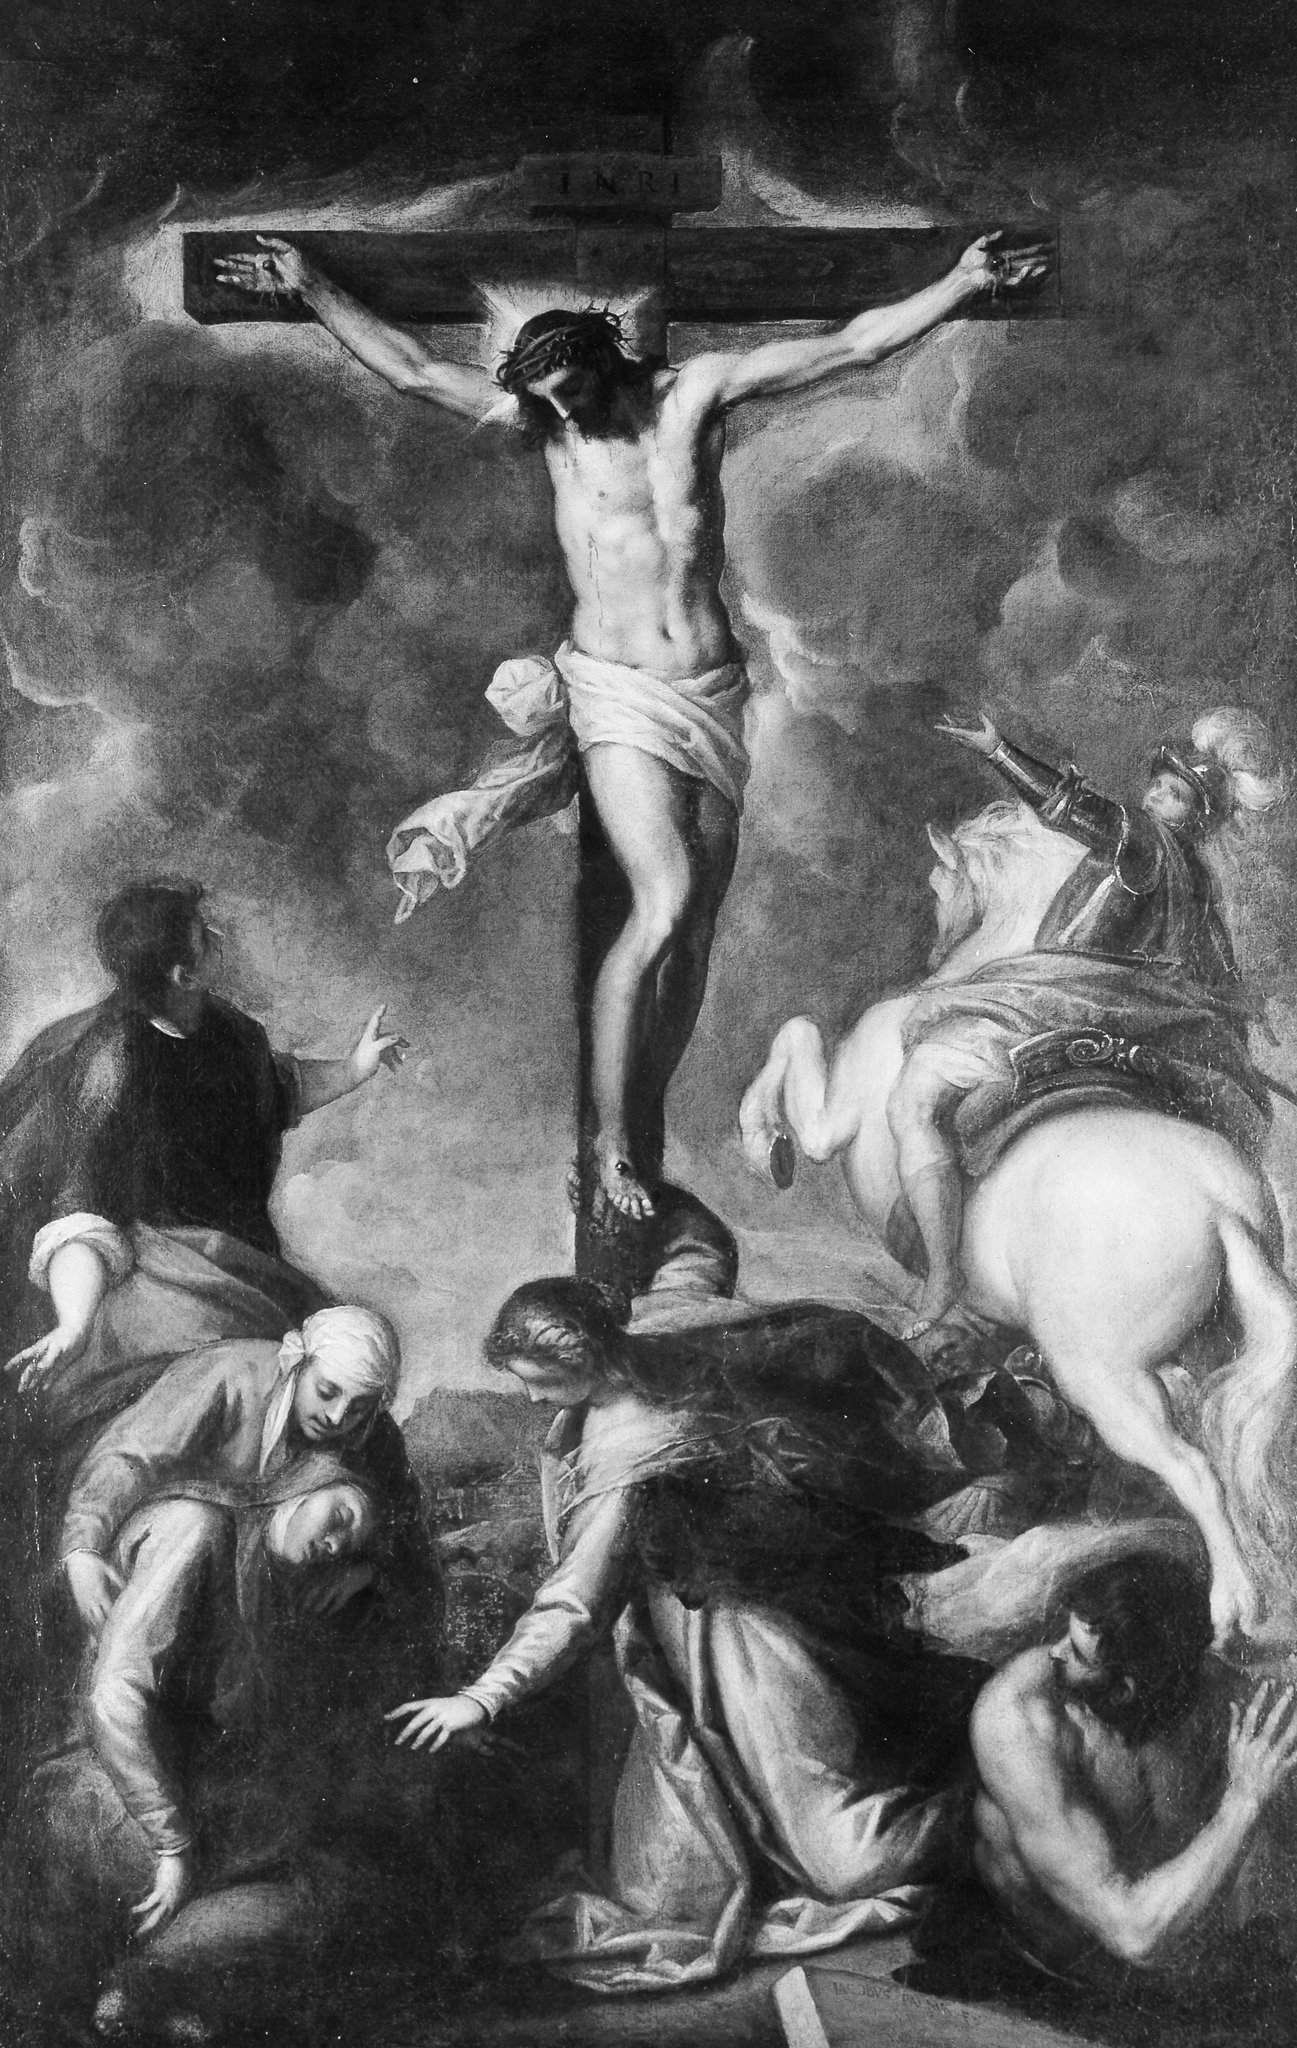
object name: painting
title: The Crucifixion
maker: jacopo palma the younger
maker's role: artist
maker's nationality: italian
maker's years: 1543-1628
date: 1564-1628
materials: canvas, oil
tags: soldiers,men,horses,christ,virgin mary,crucifixion